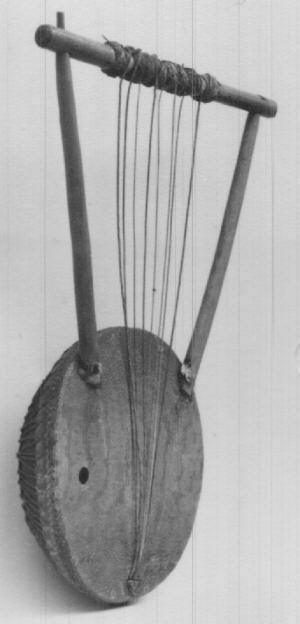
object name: endongo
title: Lyre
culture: ganda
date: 1801-1900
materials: skin, wood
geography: uganda